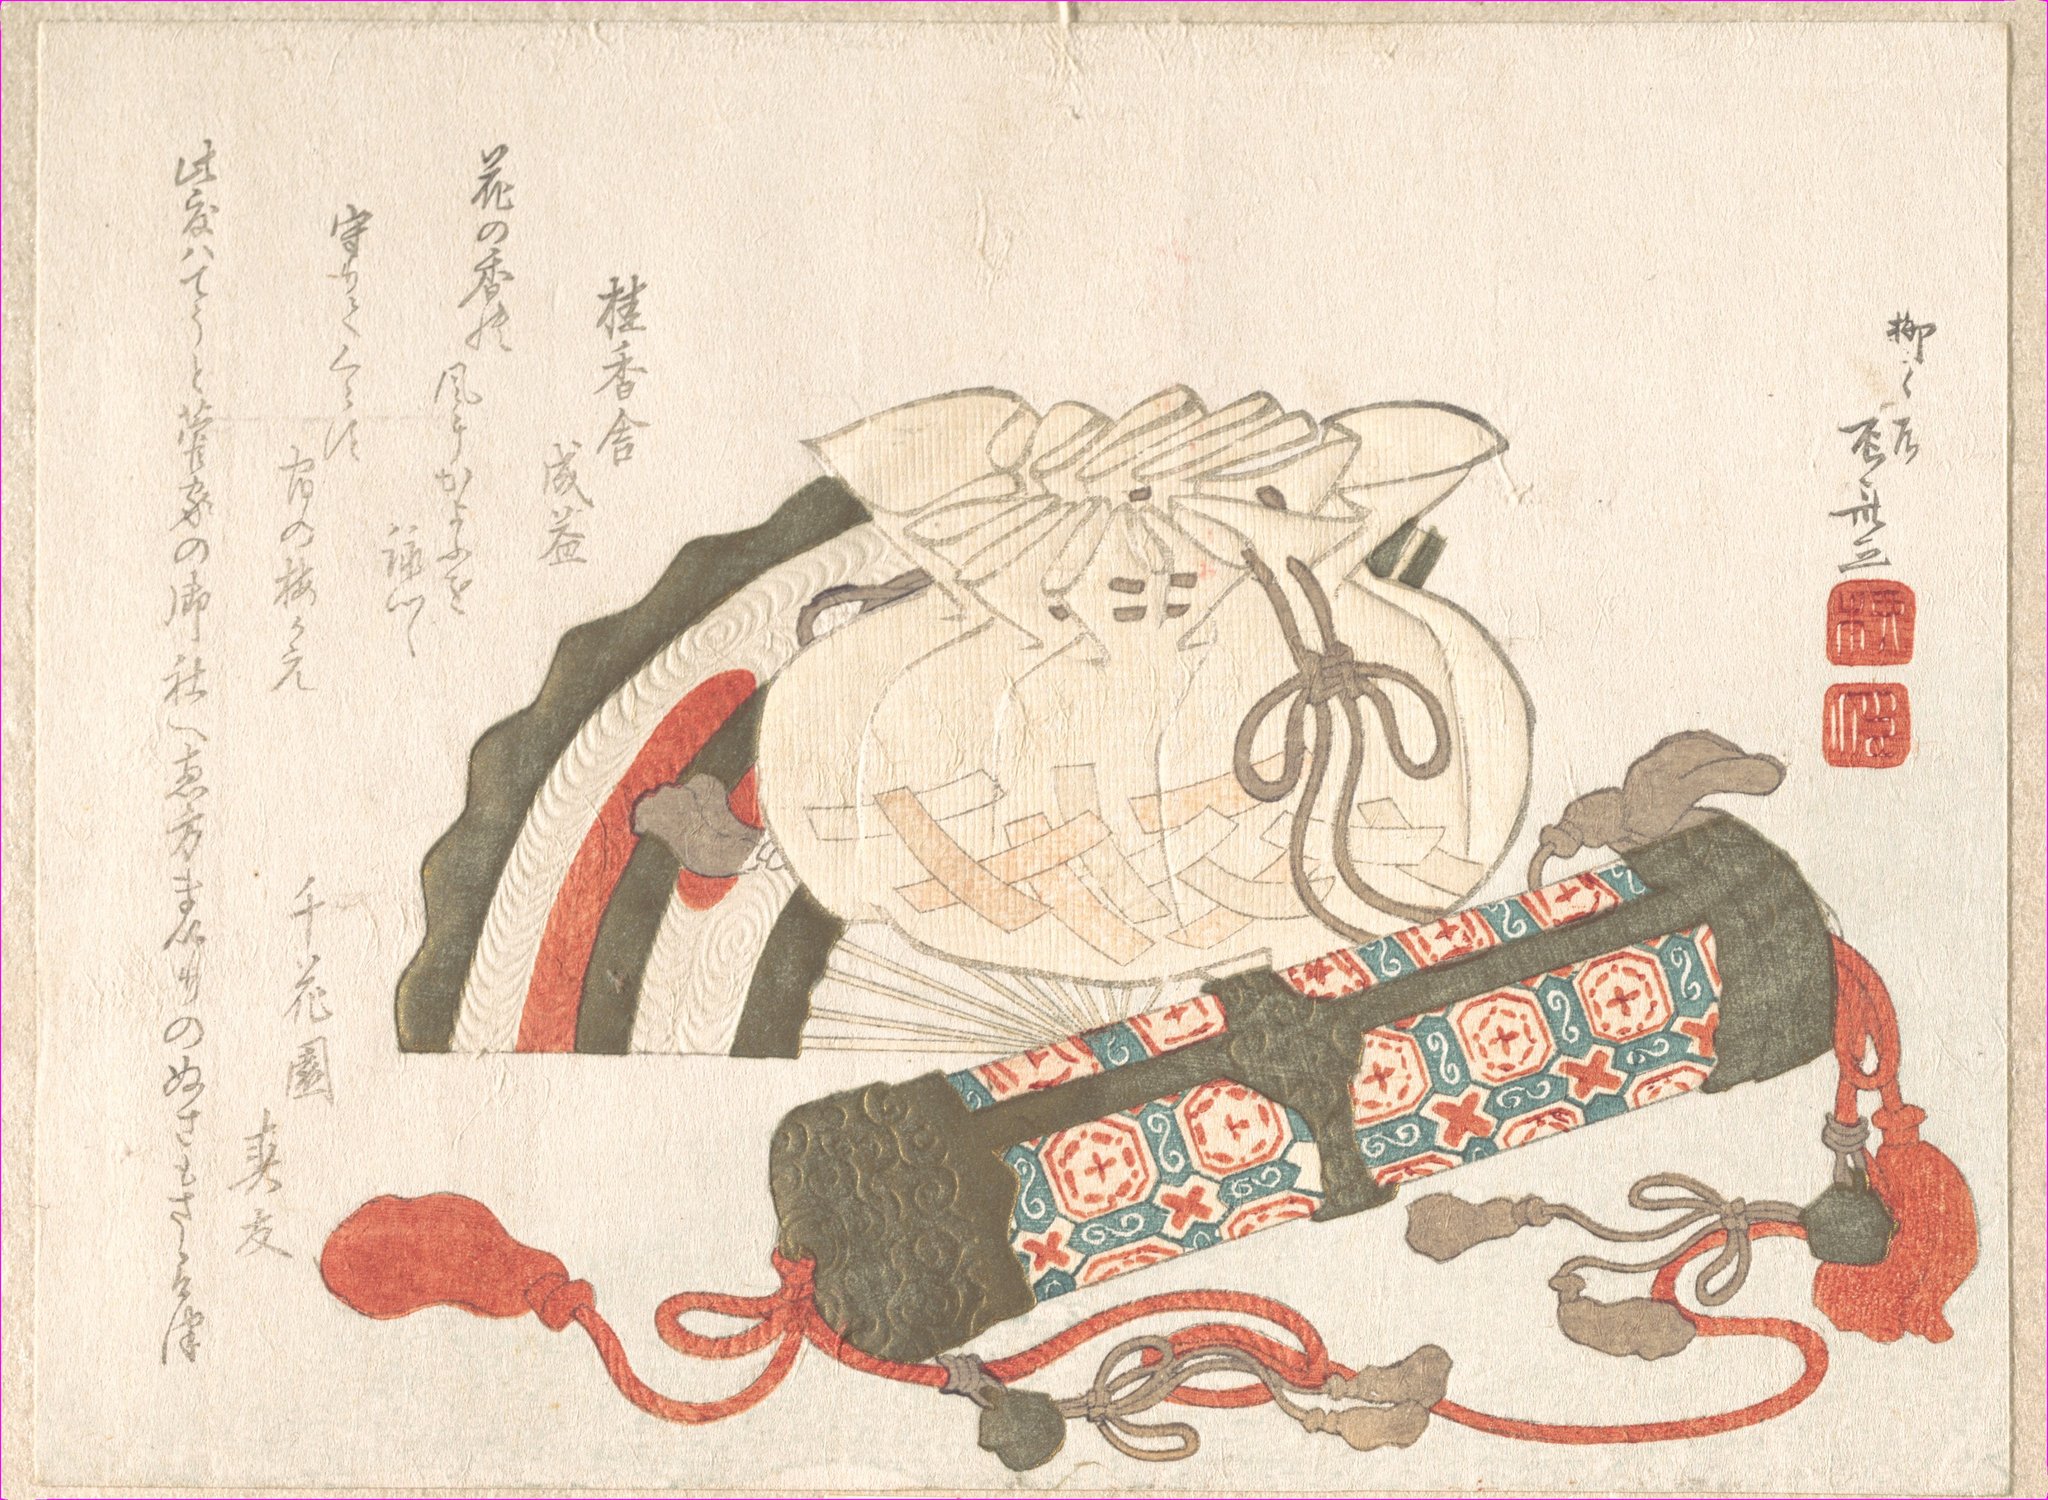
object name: print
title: Fan, Bag and Incense-Tube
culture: japanese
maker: ryūryūkyo shinsai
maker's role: artist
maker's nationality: japanese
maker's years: 1799-1823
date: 1801-1900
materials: ink, paper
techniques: surimono, woodblock print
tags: fans